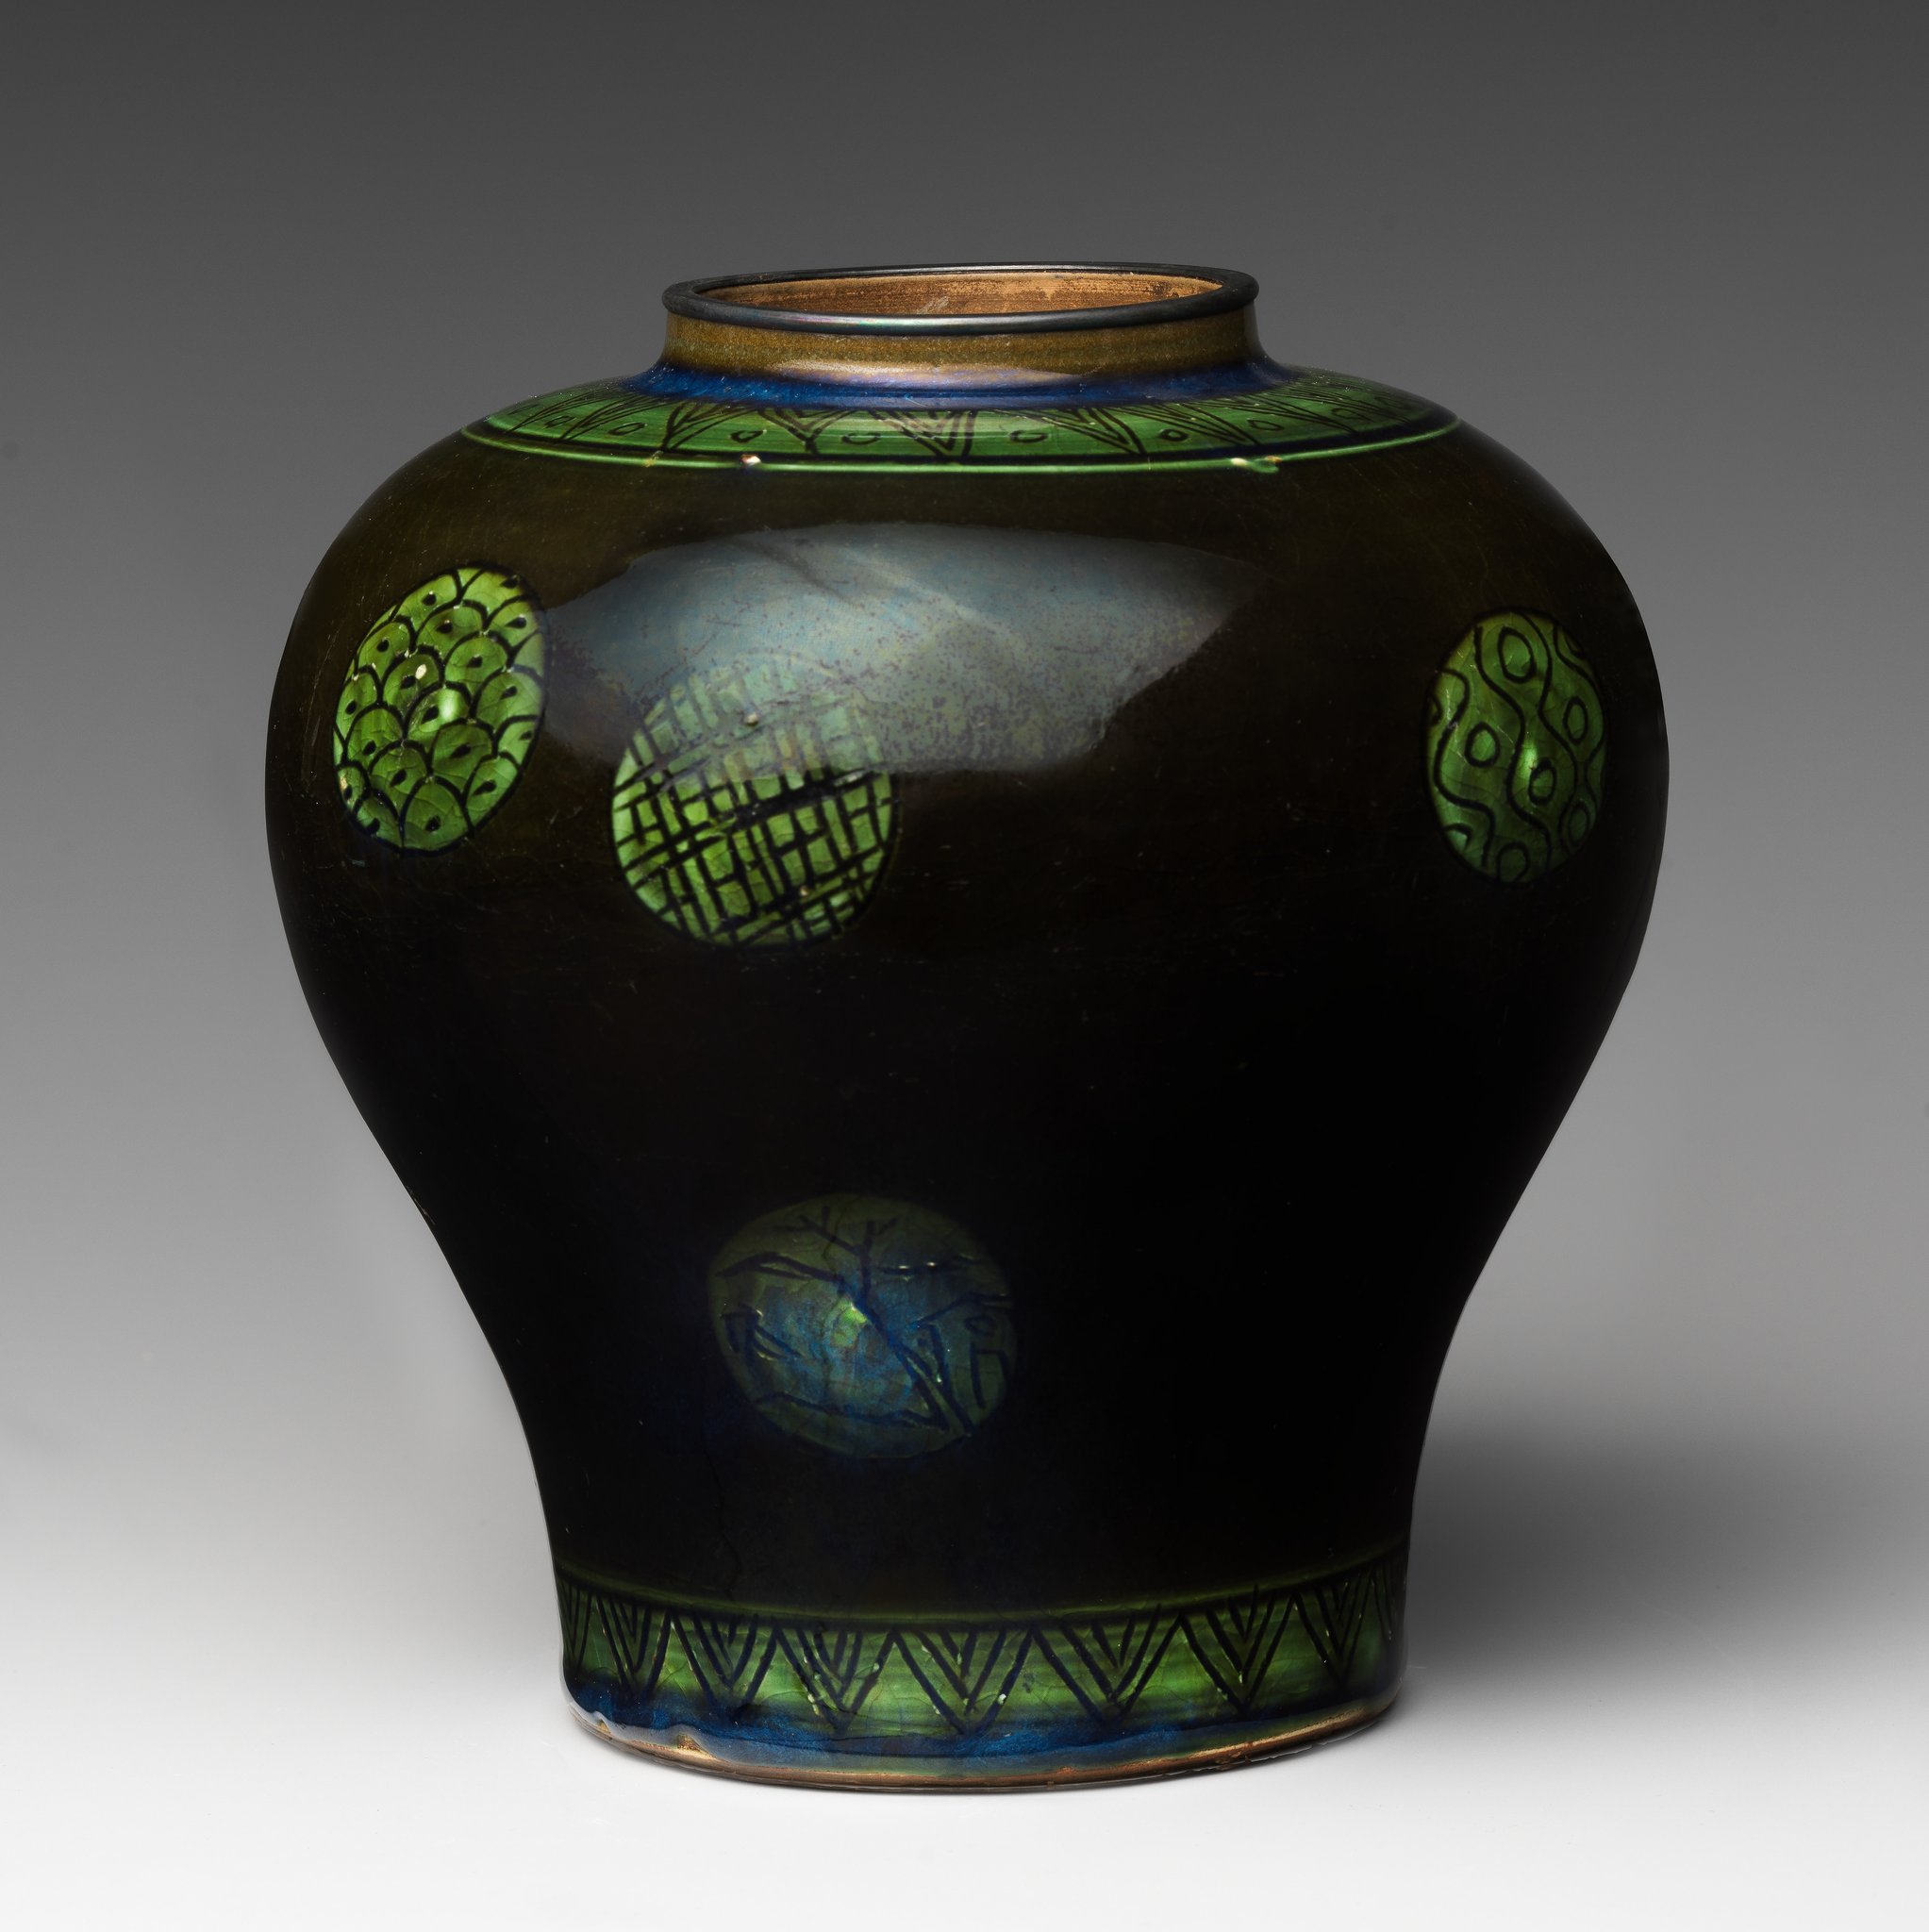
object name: jar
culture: japanese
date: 1801-1900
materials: pottery, silver